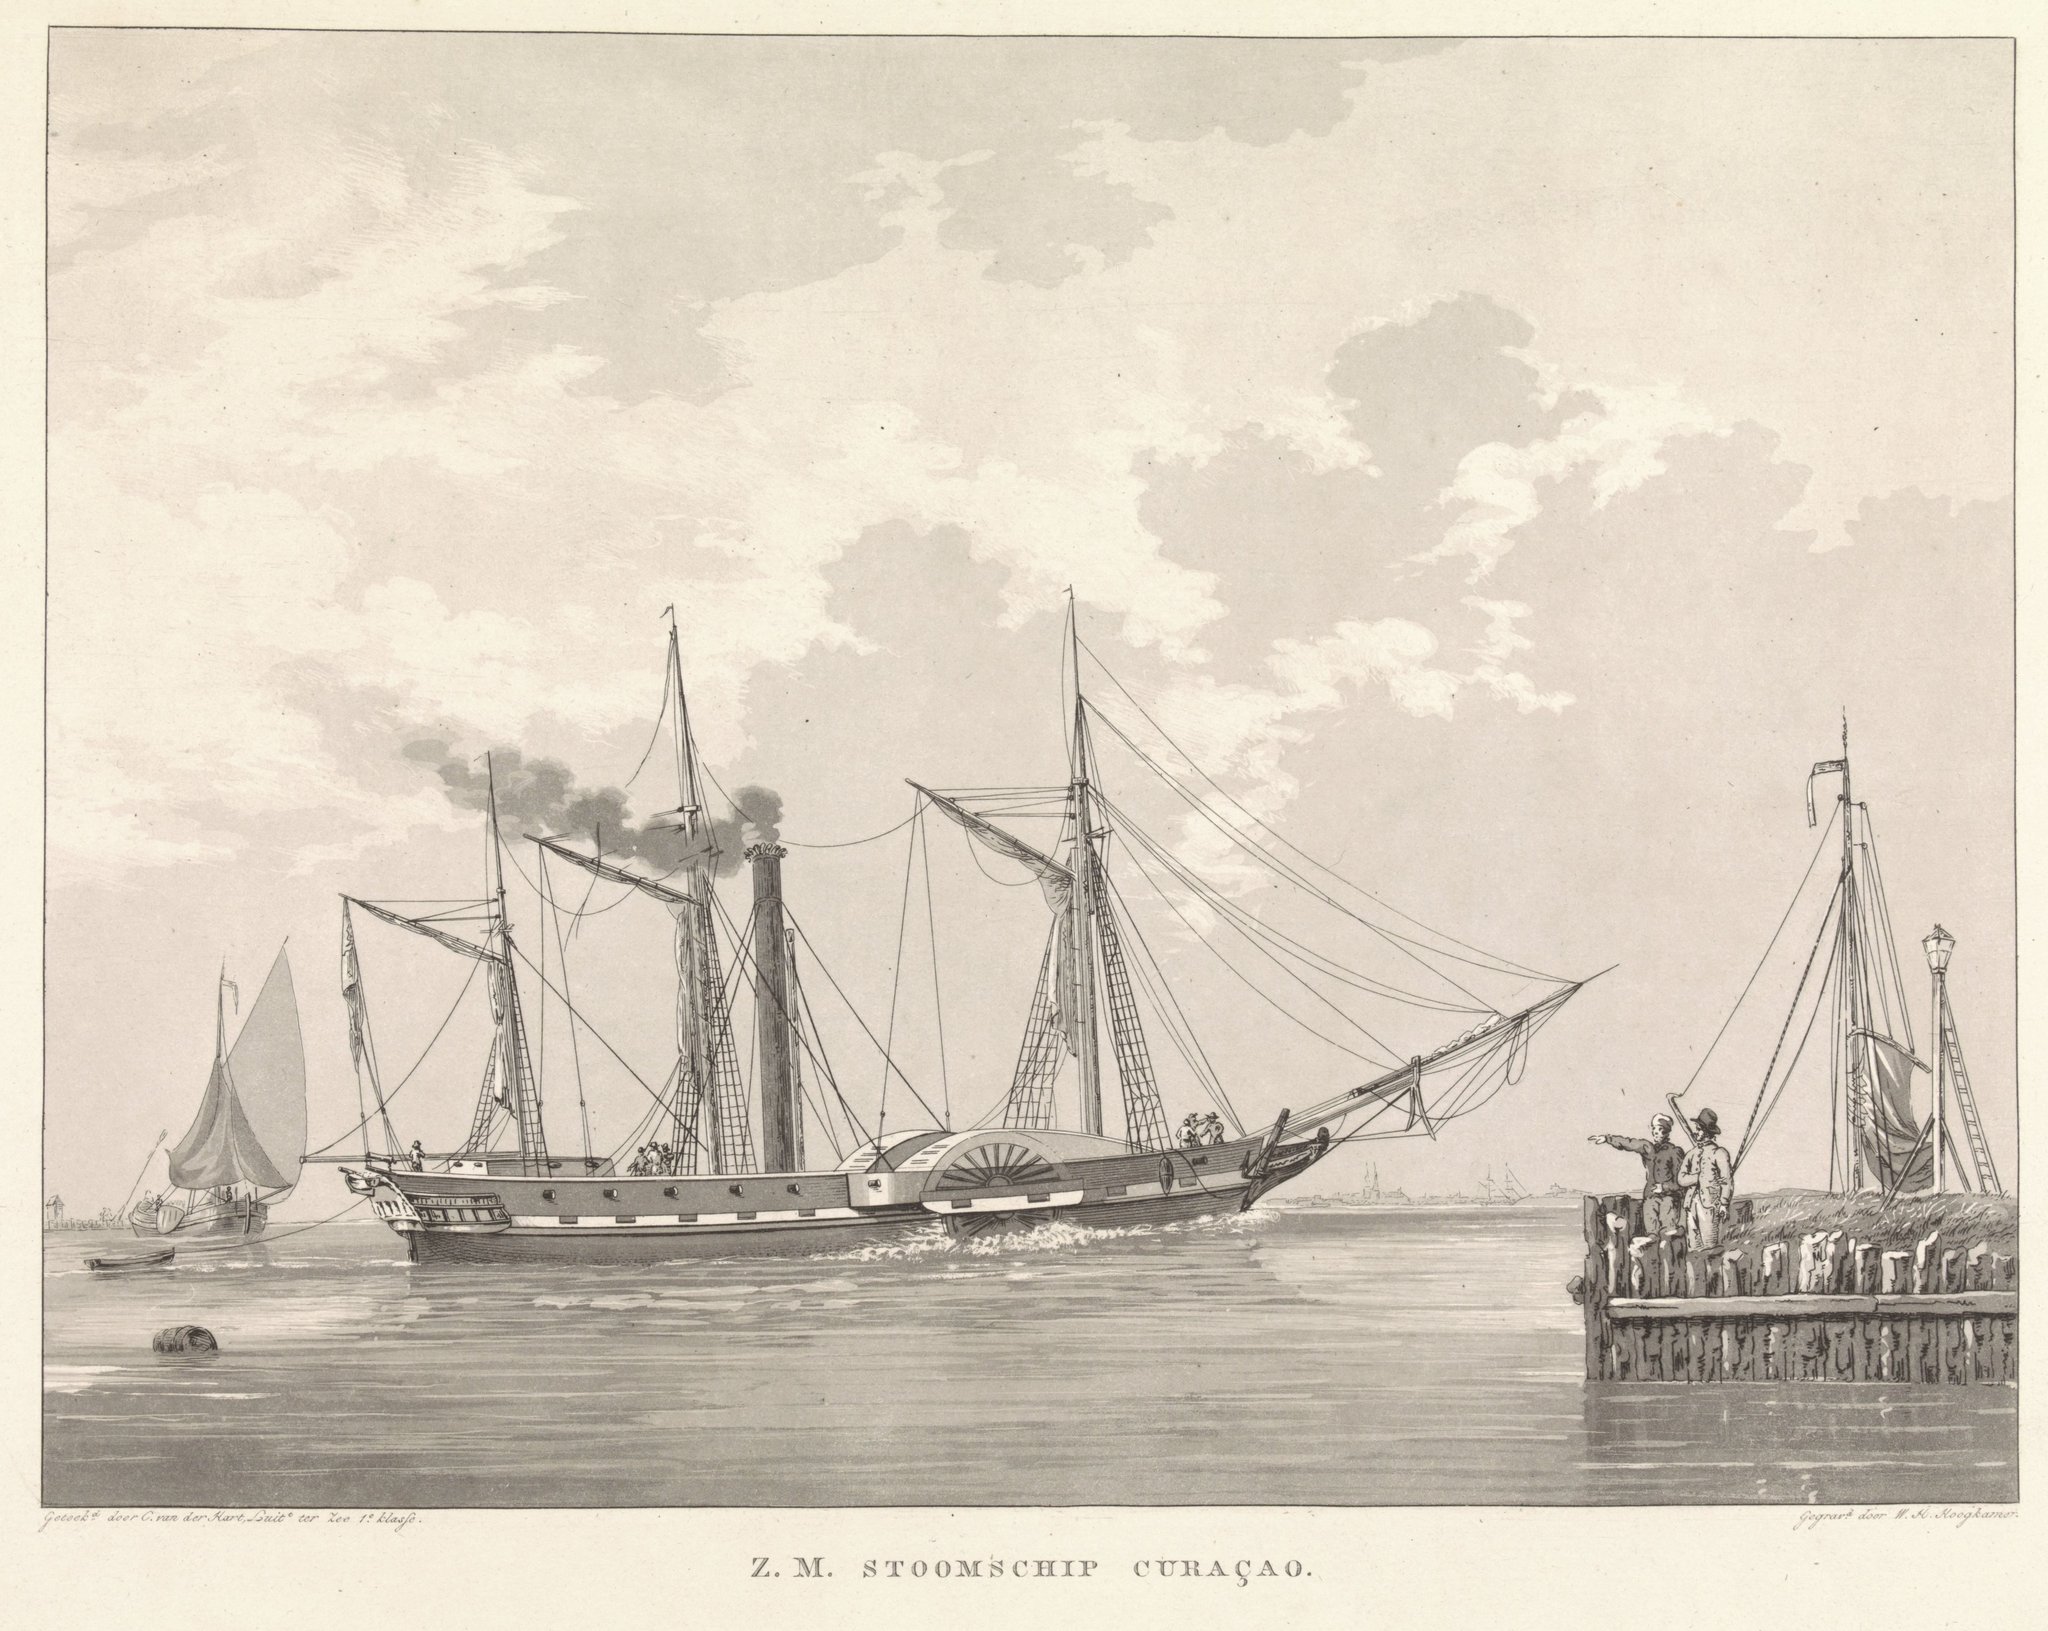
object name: print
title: Raderstoomboot bij een kade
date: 1800-1864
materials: paper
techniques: aquatint, etching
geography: netherlands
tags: steamship, motorship, paddle-wheel boat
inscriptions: collector's mark: Lugt 2228, collector's mark: Lugt 2760